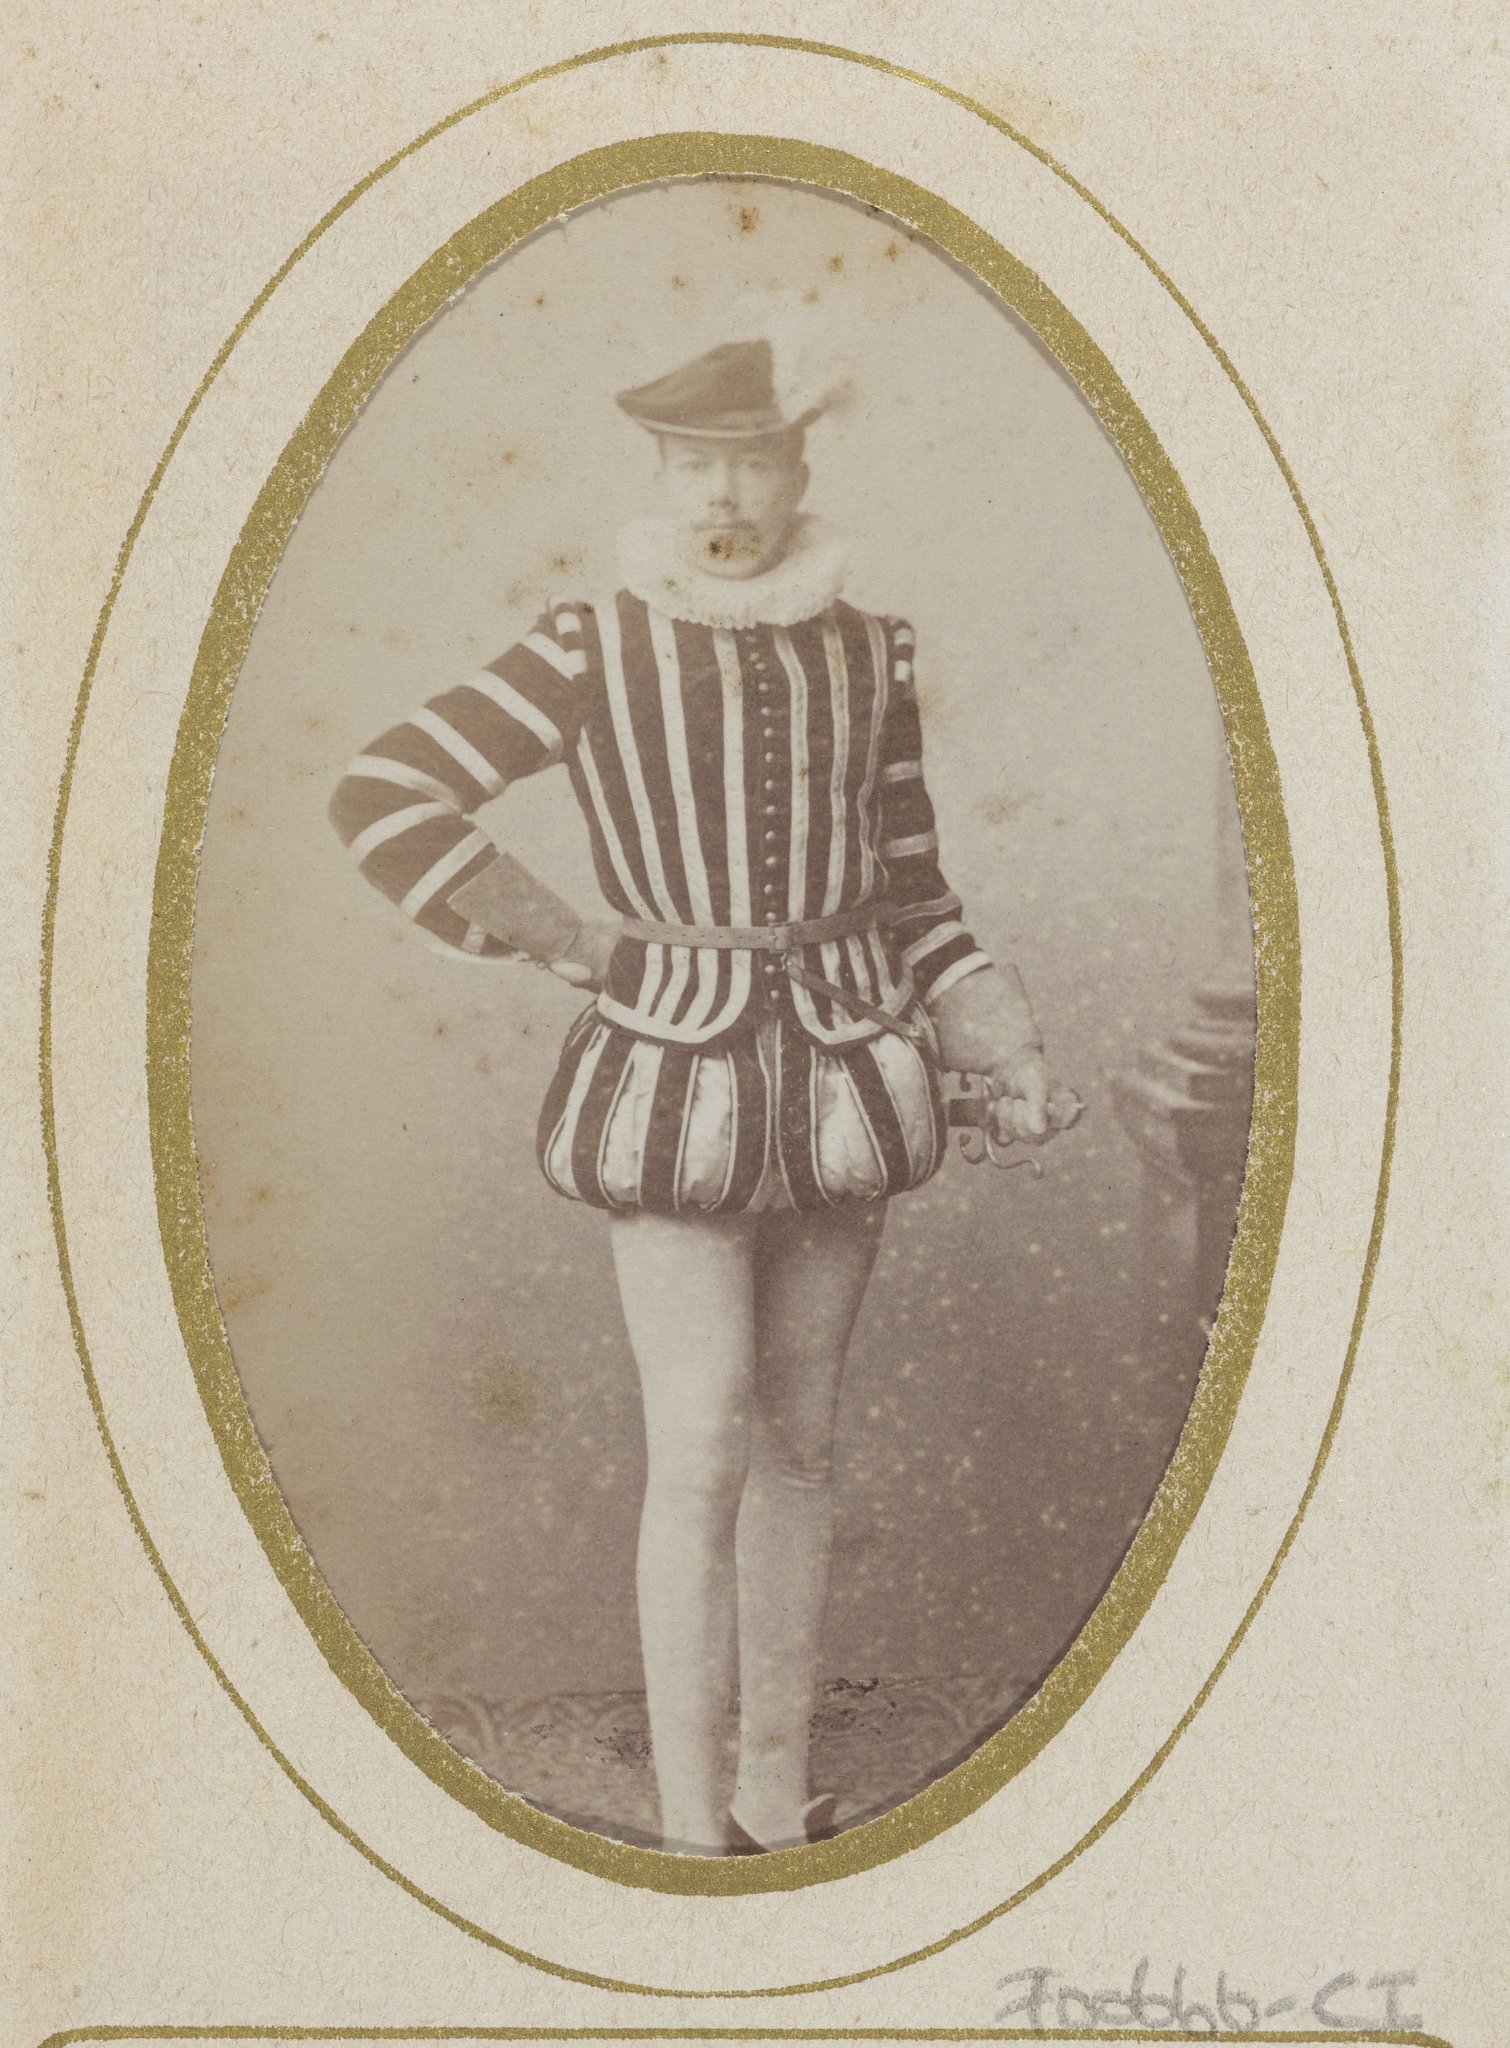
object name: album leaf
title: Portret van een jonge man in kostuum, mogelijk François Haversmidt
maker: jan goedeljee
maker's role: fotograaf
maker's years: 1824-1905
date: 1860-1870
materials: cardboard, photographic support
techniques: albumen print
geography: leiden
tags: historical persons, historical costume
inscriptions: inscription: ‘J. Goedeljee/ Photograaf/ Z. K. H. PRINS ALEXANDER/ der Nederlanden/ PRINS van ORANJE/ en H. K. H./ PRINSES HENDRIK/ der Nederlanden/ Hoogewoerd 160/ nabij de Plantage.’, name: ‘F. Haver Smi[d]t/ 131.’